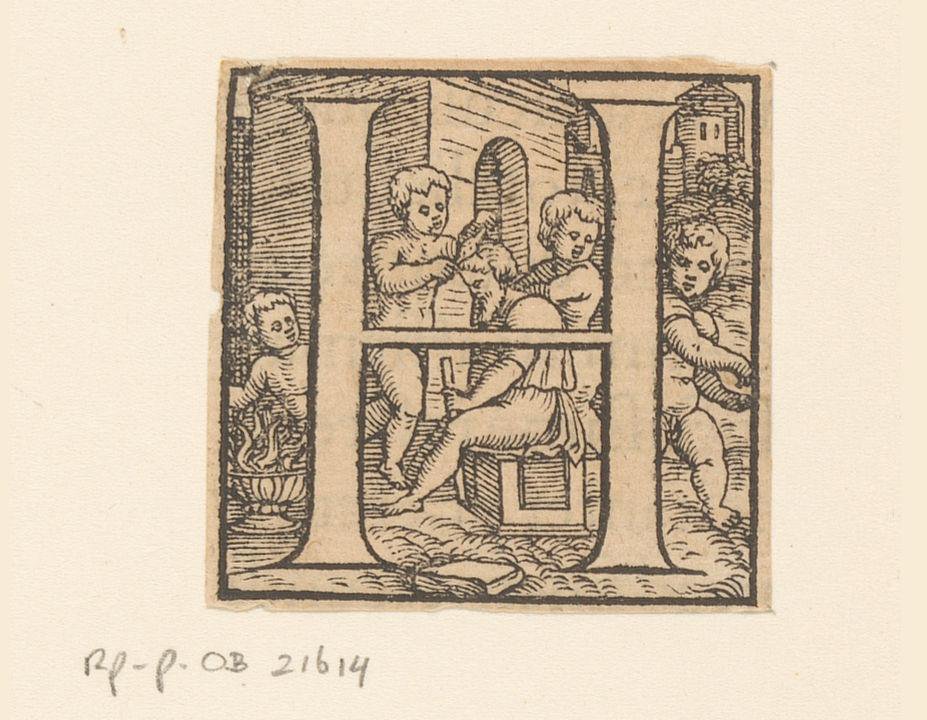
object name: book illustration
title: Versierde initialen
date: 1543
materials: paper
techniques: woodcut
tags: letters, alphabet, script, physiology and anatomy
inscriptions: collector's mark: Lugt 2227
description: Prent uit: Vesalius, Andreas. De Humani Corporis Fabrica. Bazel: Jan Herpst, 1543.